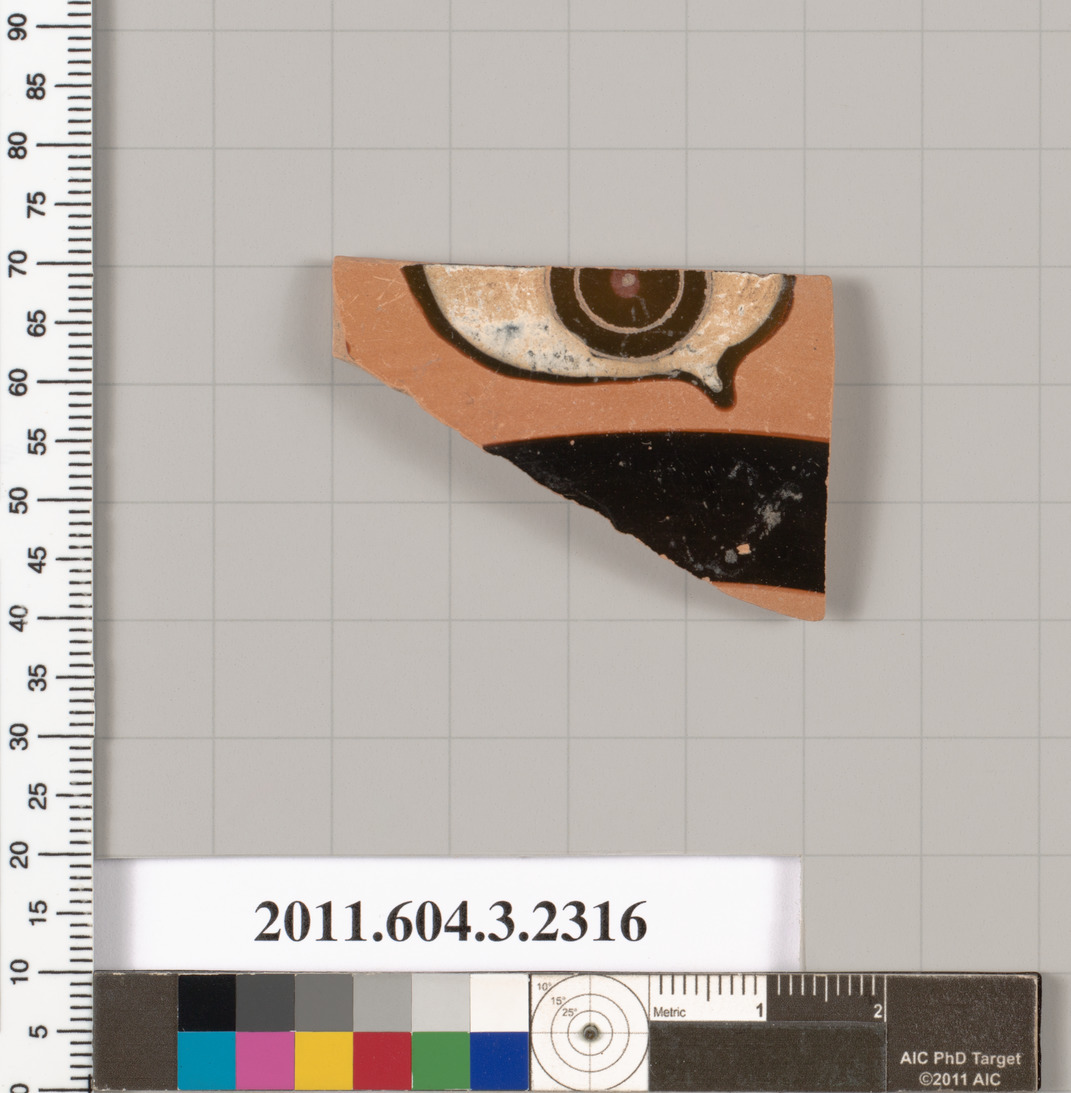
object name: kylix fragment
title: Terracotta fragment of a kylix: eye-cup (drinking cup)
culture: greek, attic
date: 530-510 BCE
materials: terracotta